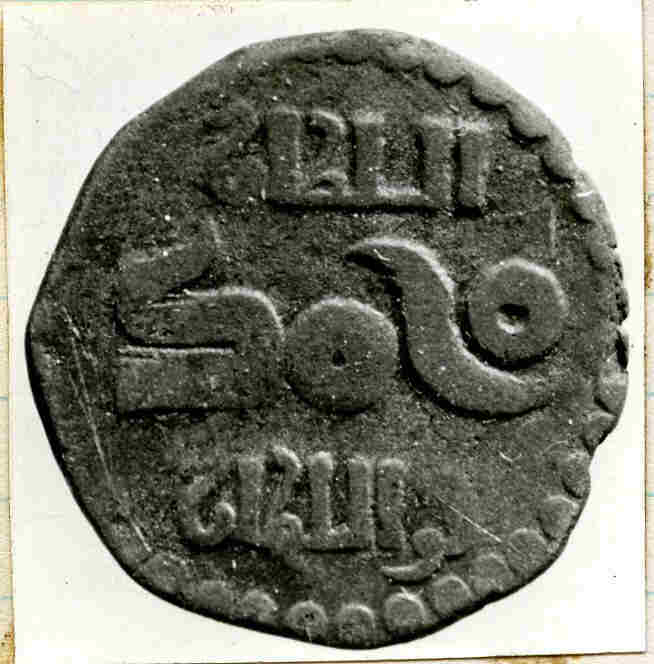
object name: coin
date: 1067-1233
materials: copper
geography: iran